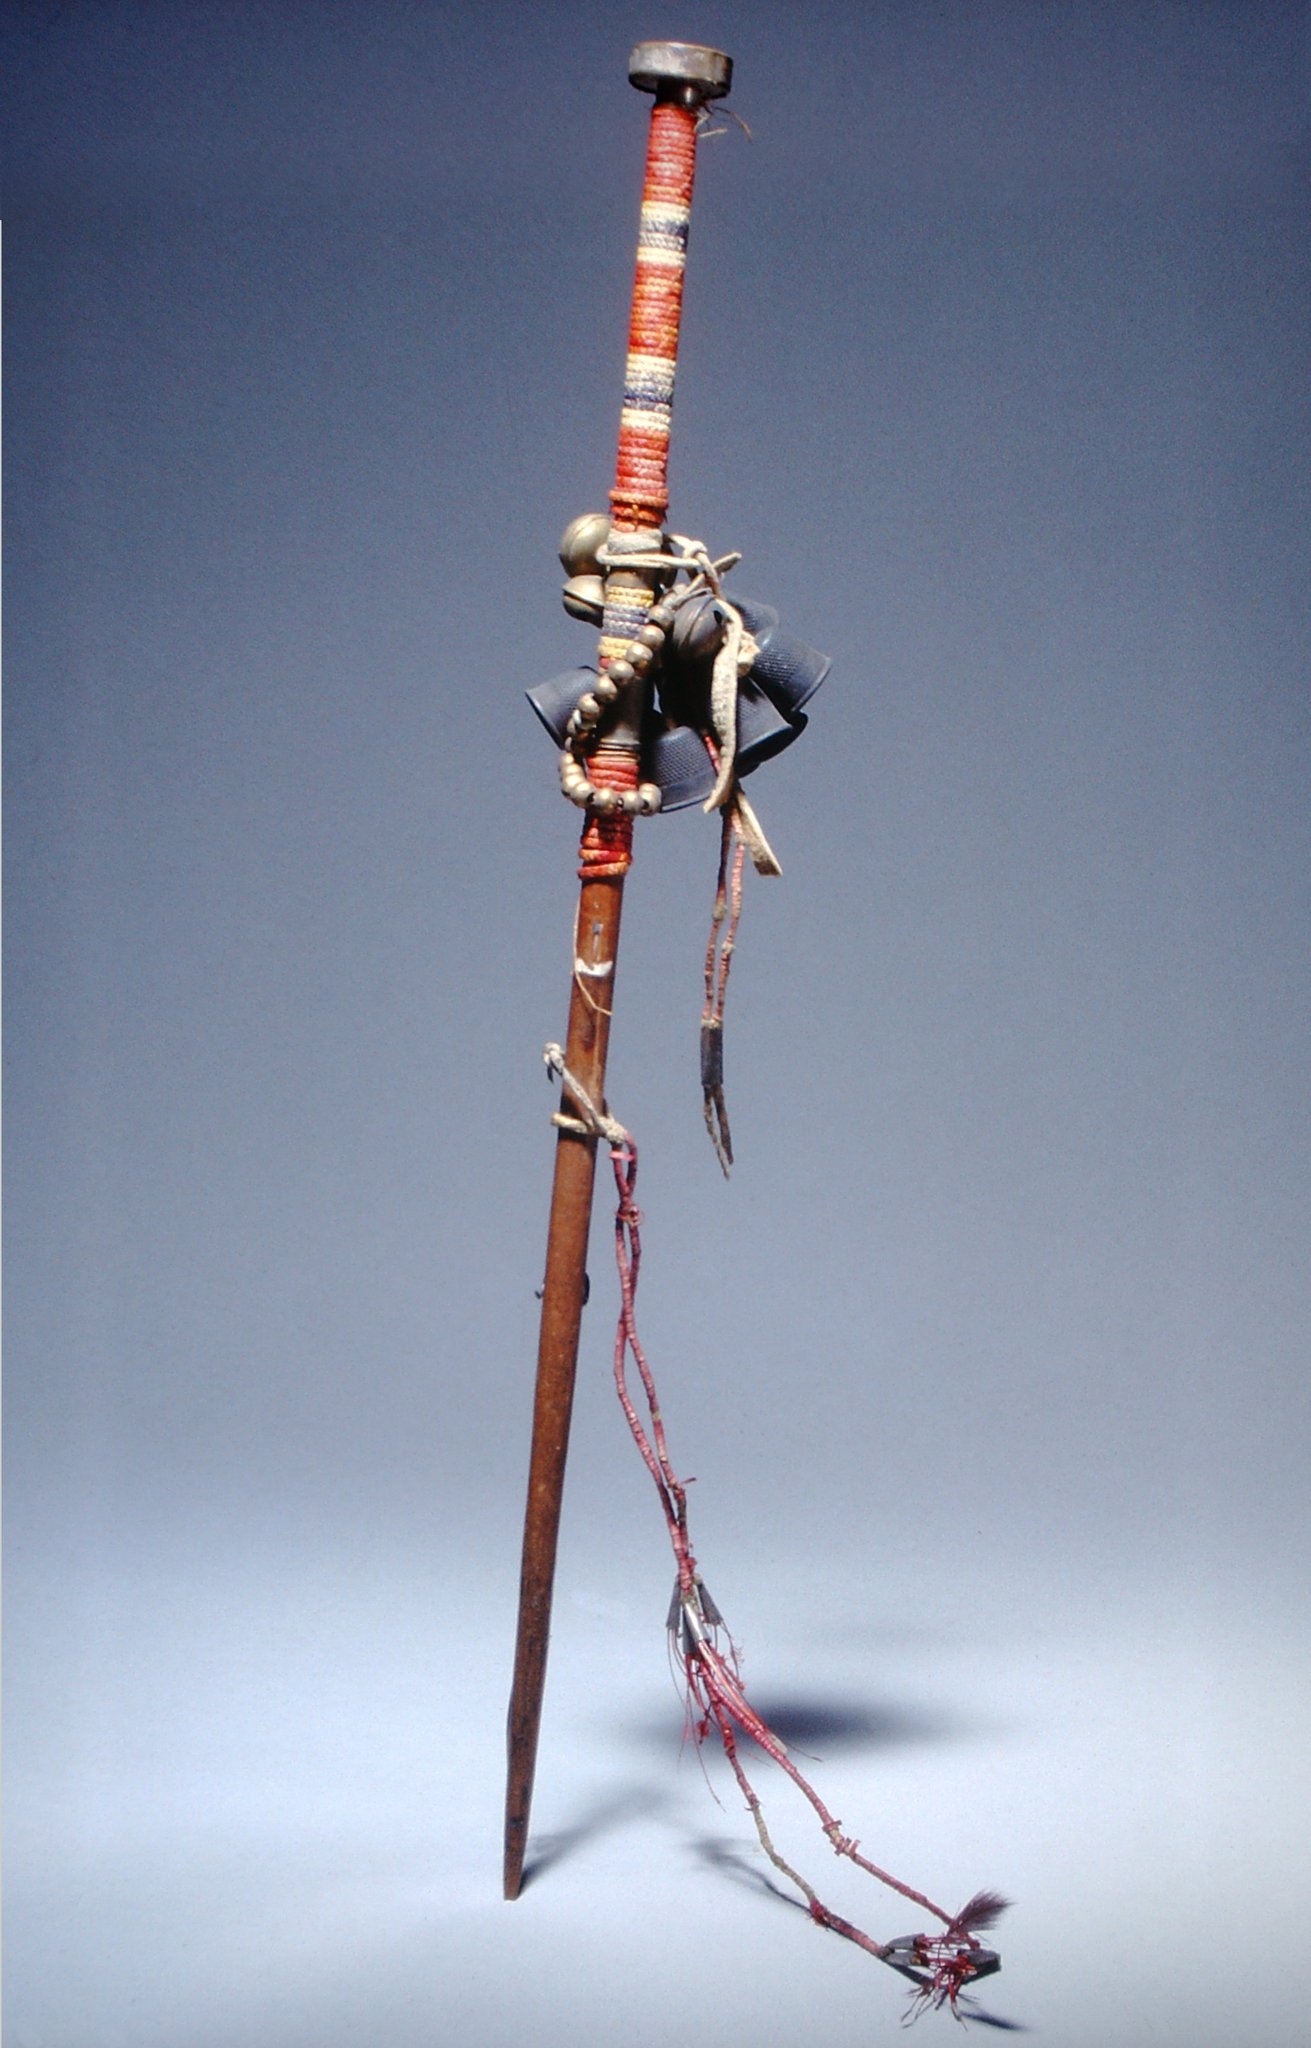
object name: napo shampidah hah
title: Napo-Shampidah-Hah (stick rattle)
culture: native american, sioux or dakota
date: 1801-1900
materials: brass, feather, tin, wood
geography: united states